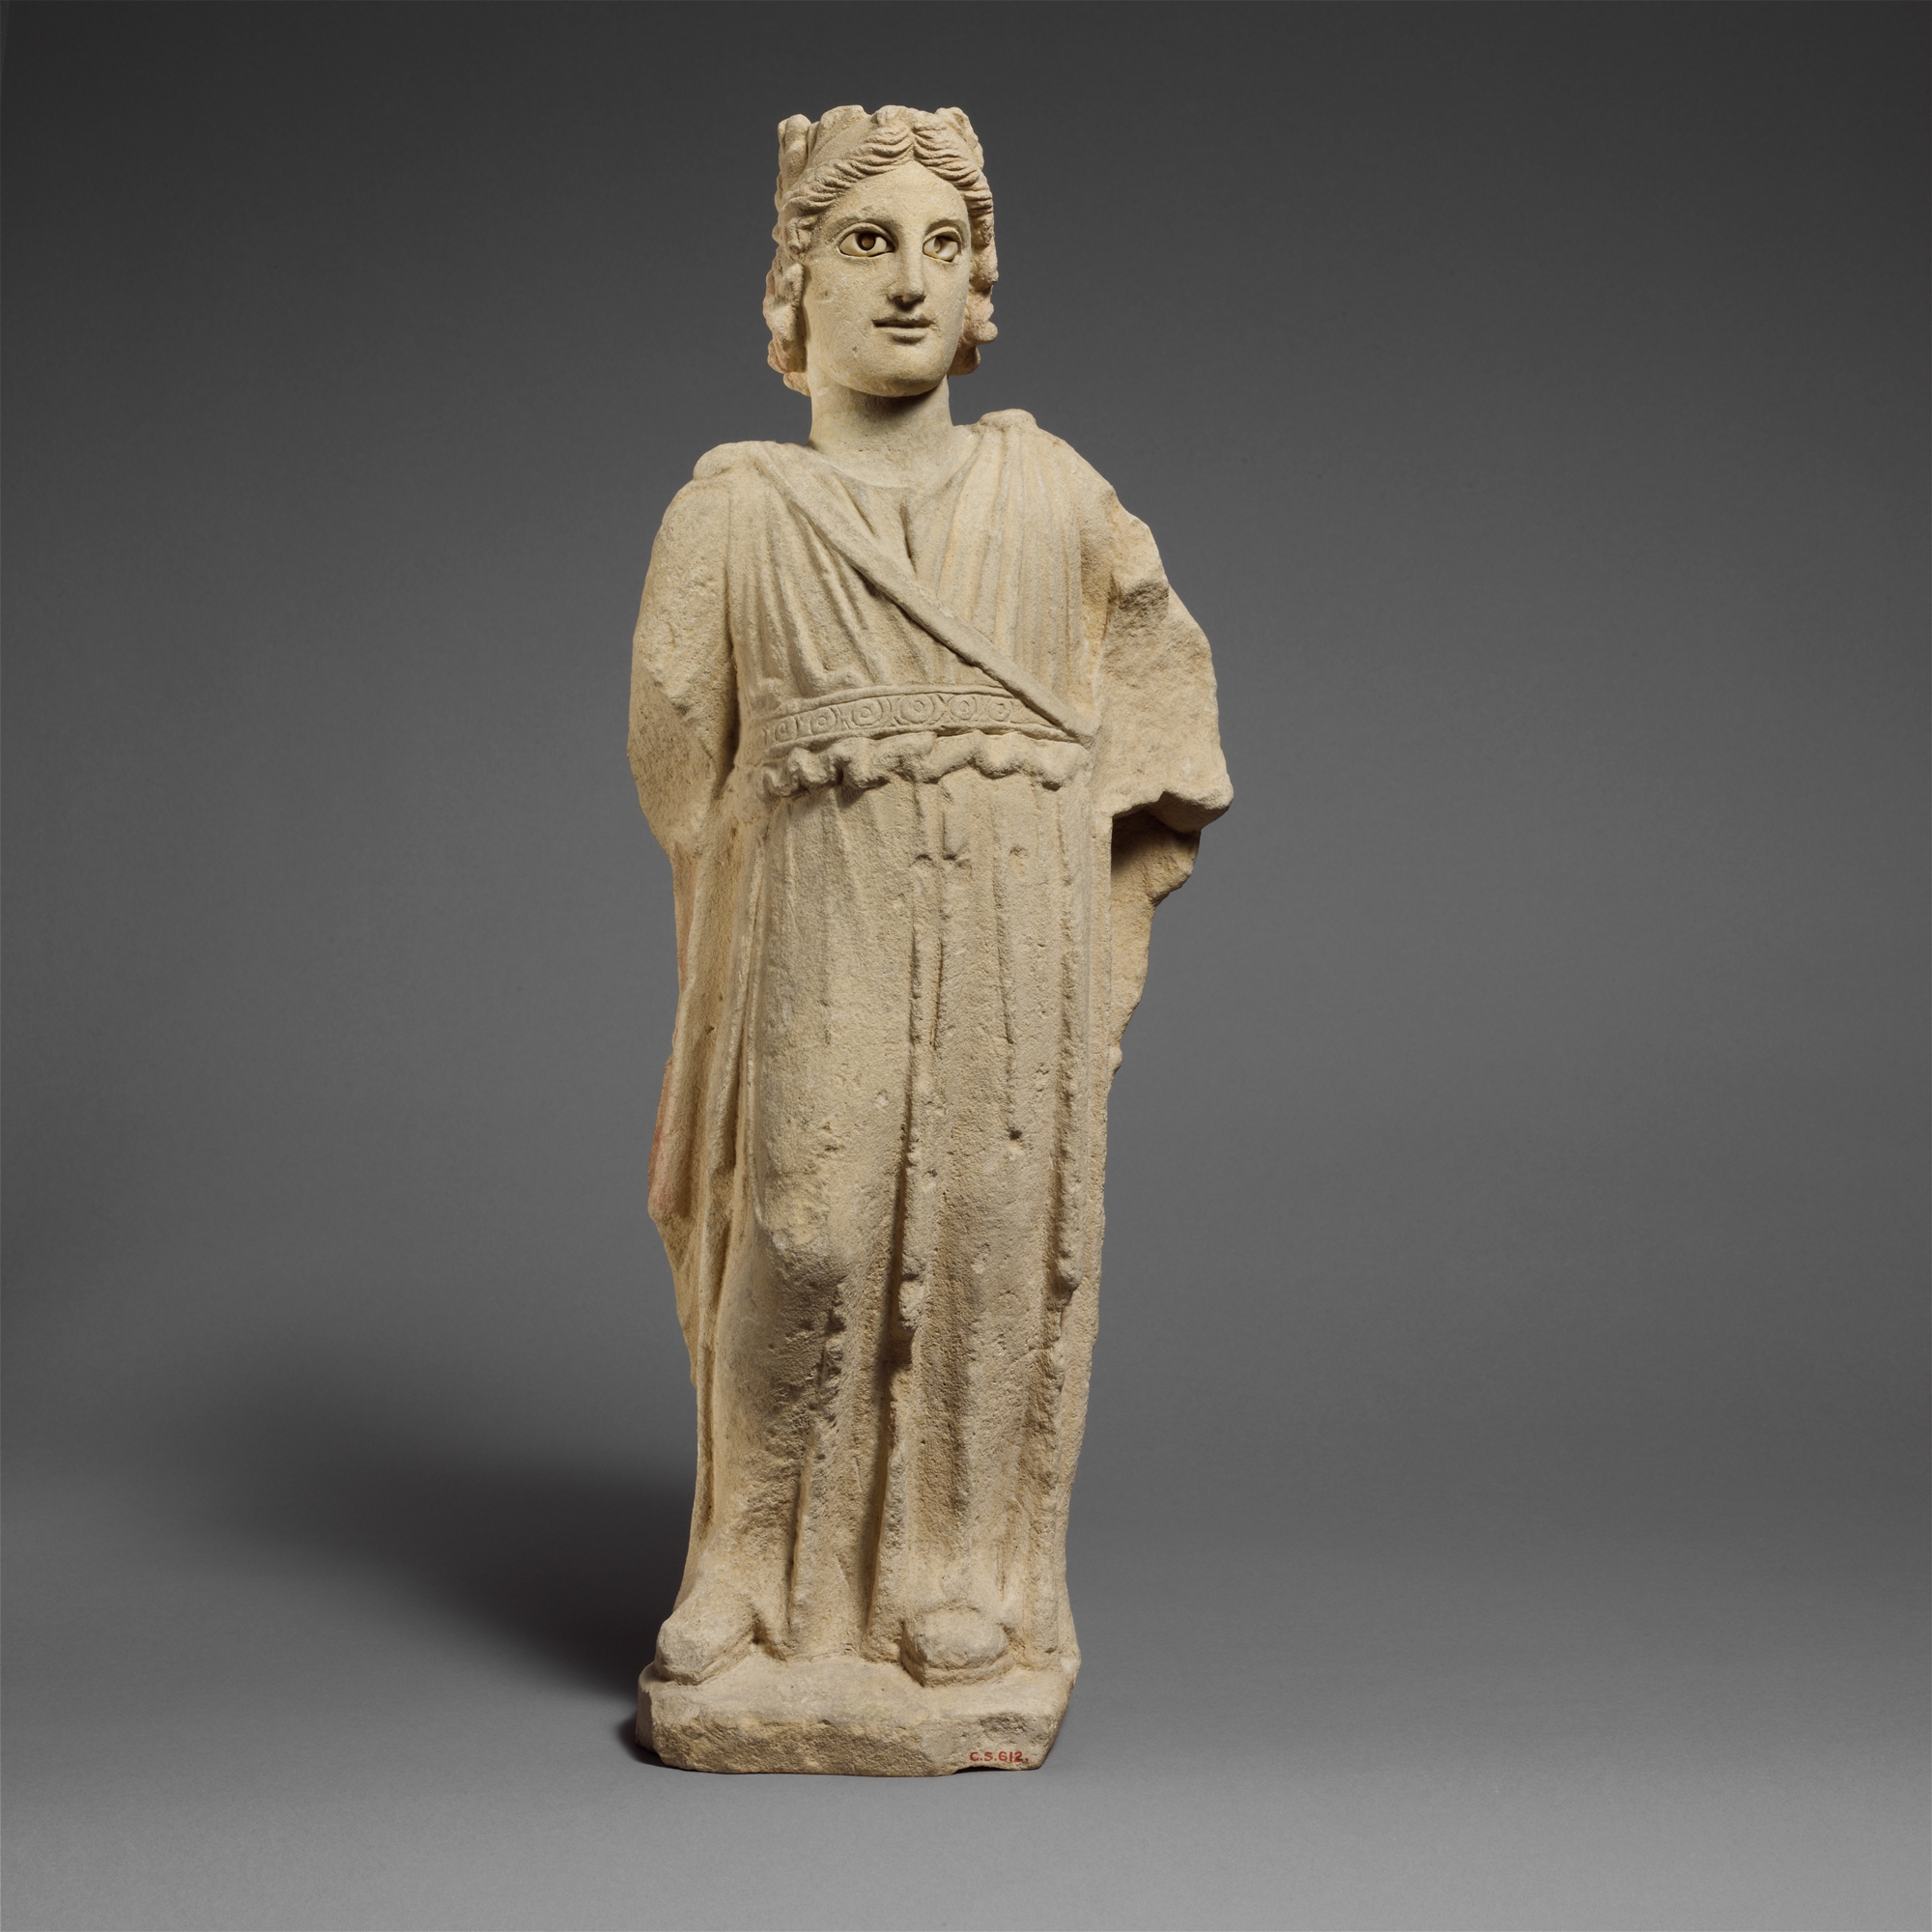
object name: statue of a youth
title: Limestone statue of Apollo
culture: cypriot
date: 300-1 BCE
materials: limestone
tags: apollo